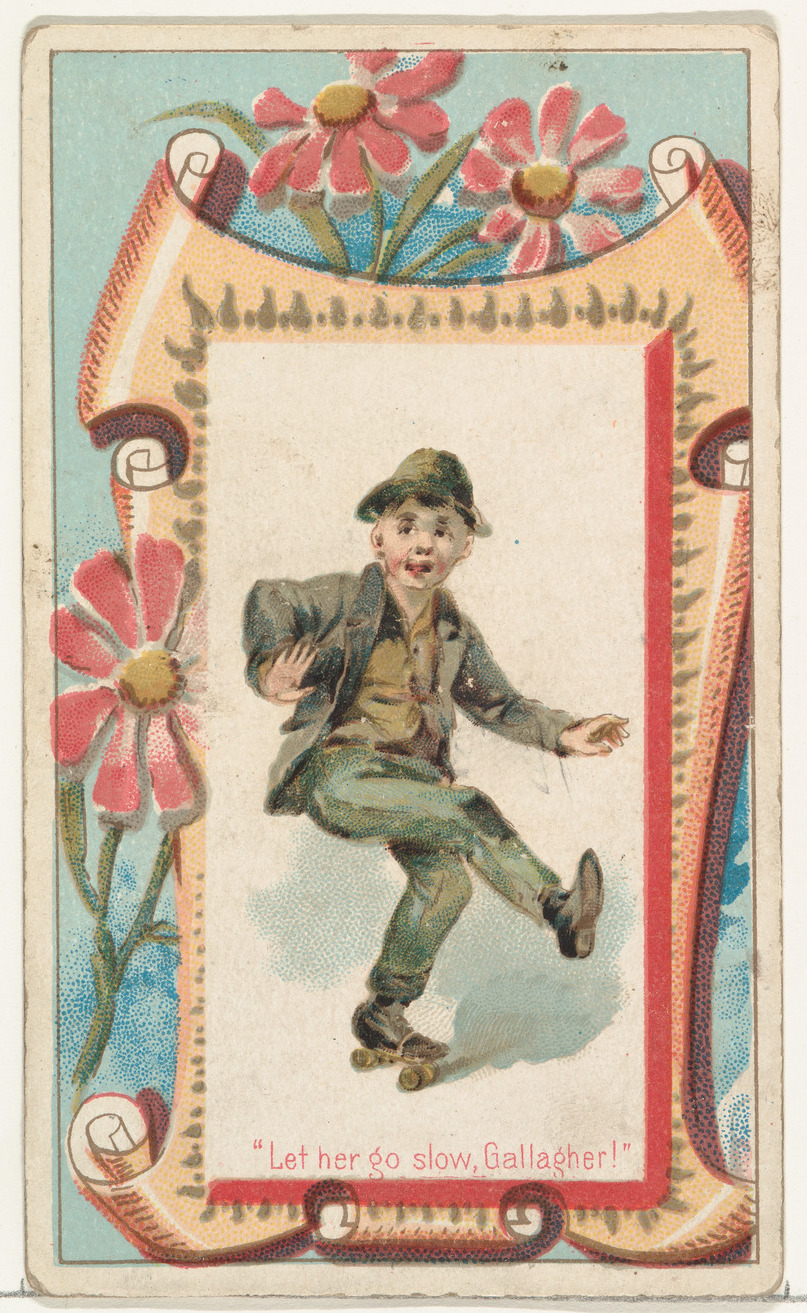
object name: print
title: "Let her go slow, Gallagher," from the Terrors of America set (N136) issued by Duke Sons & Co. to promote Honest Long Cut Tobacco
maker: w. duke, sons & co.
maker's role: publisher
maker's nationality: american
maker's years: 1870-1920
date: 1888-1889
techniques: color lithograph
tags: boys,flowers